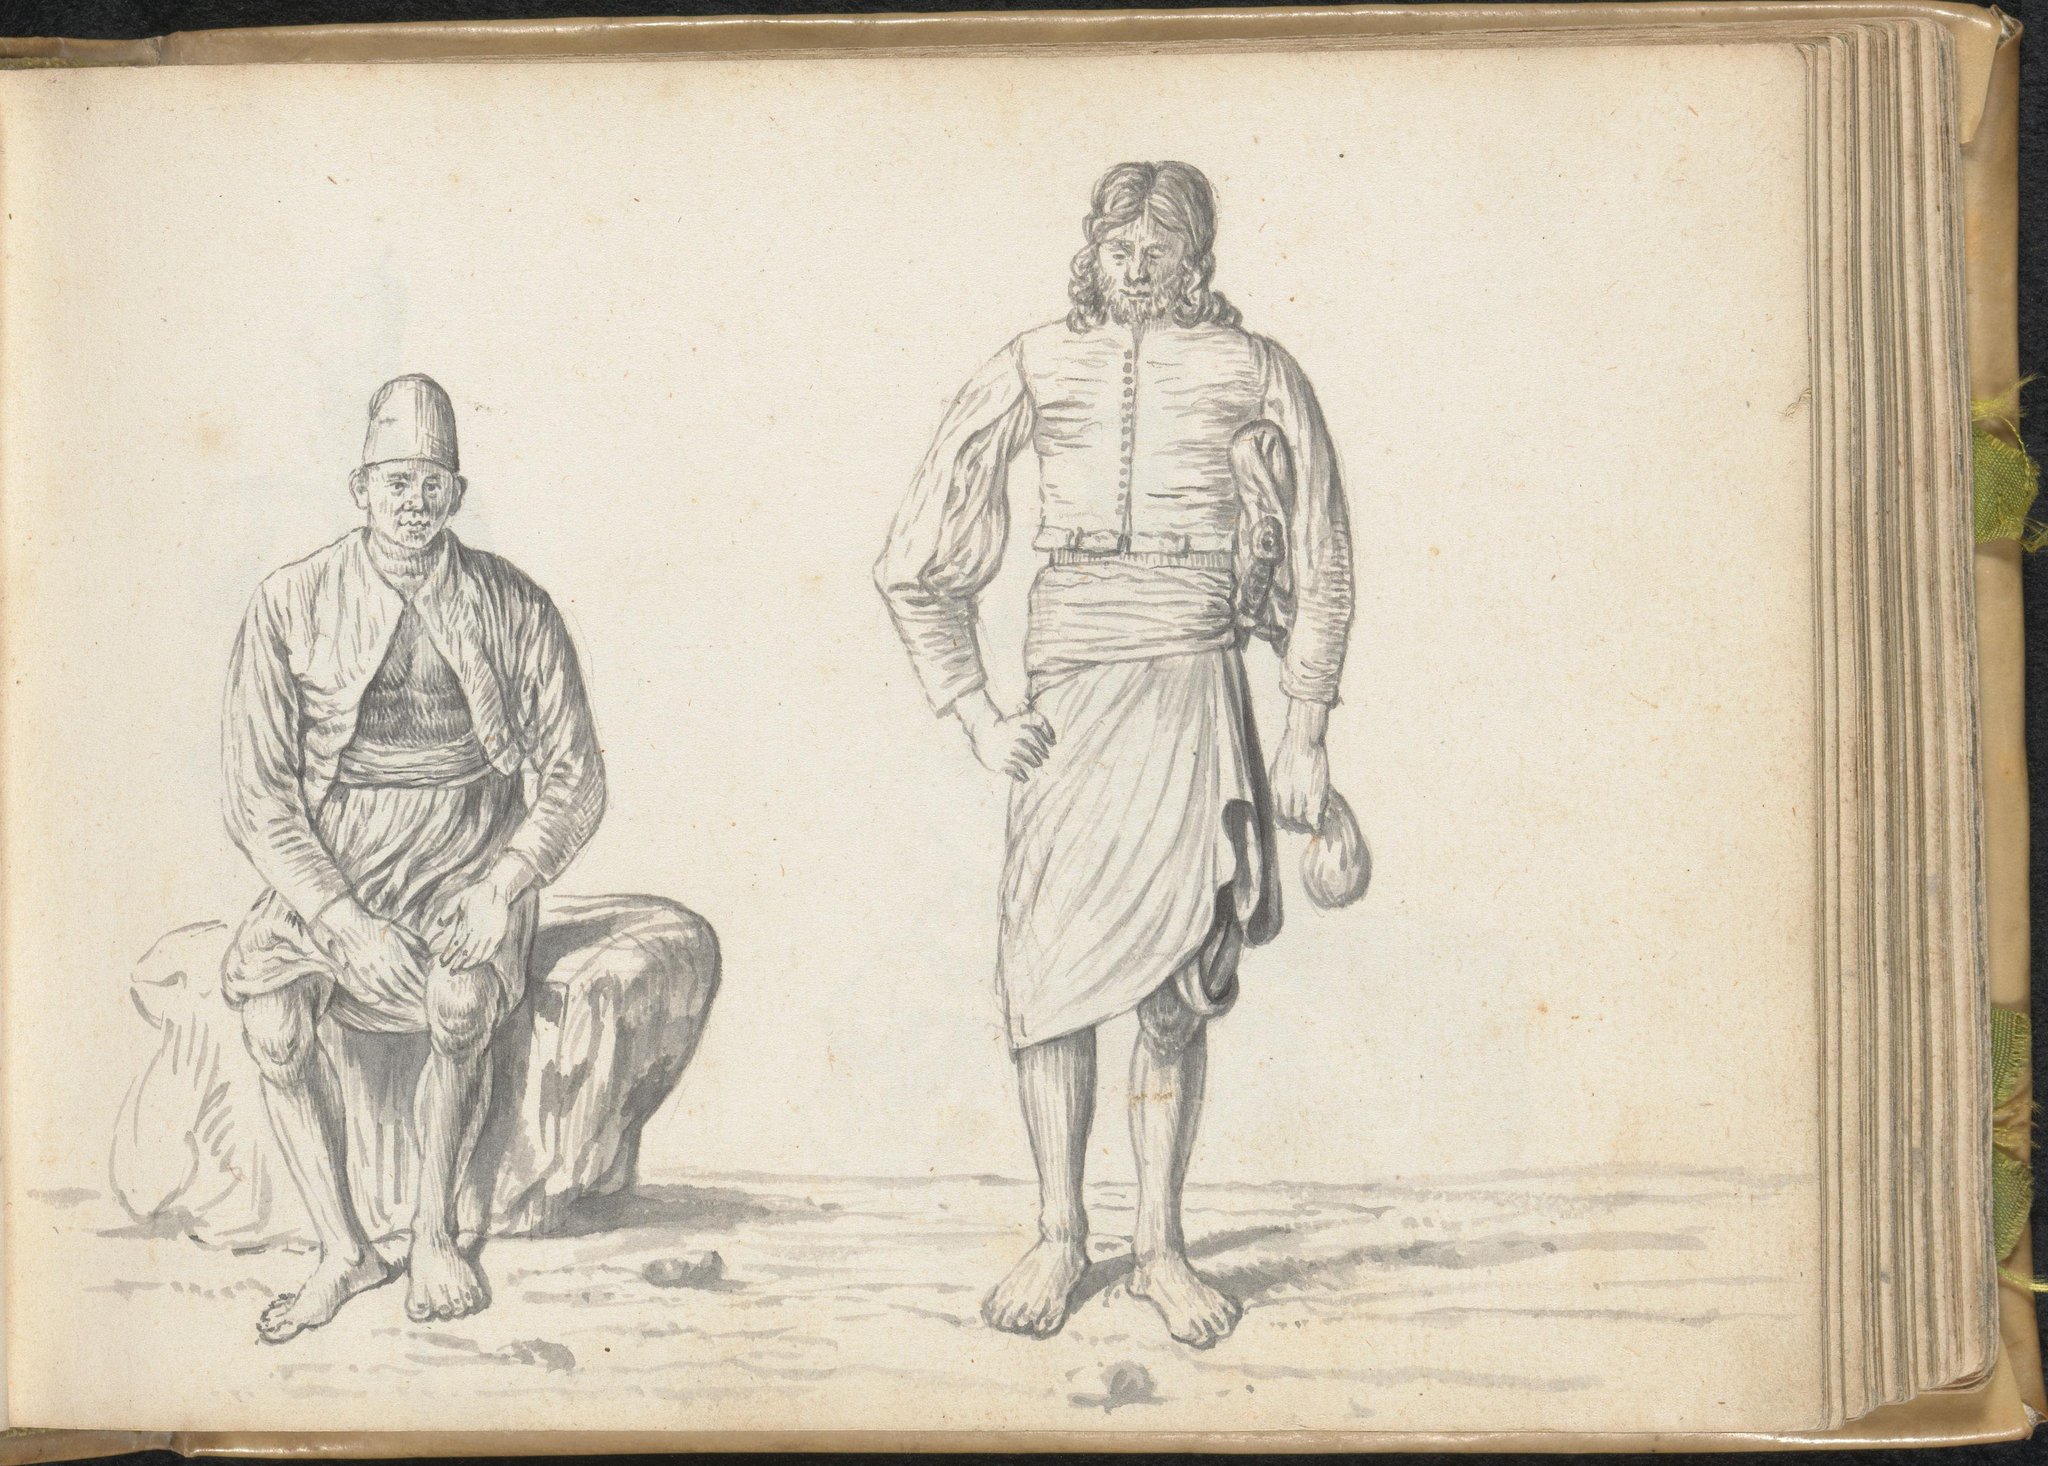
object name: sketchbook leaf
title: Two Sinhalese soldiers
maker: esaias boursse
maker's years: 1631-1672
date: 1662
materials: ink, paper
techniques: brush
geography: sri lanka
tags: asiatic races and peoples (srilankans), asiatic races and peoples (with name), skirt (dhoti), 41d232(...) skirt (lungi), hacing and thrusting weapons (with name), the soldier; the soldier's life, sri lanka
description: In de buitenlucht poseren twee mannen frontaal voor de tekenaar. Hun voeten en onderbenen zijn bloot. De man links zit op een rotsblok. Hij draagt een tot boven de knieën opgeschort heupkleed (veshti, lungi) met een tailleband, een openhangend kort jasje met lange mouwen en geplooide onderrand (hettaya) en een eenvoudige hoge muts op zijn hoofd boven zijn oren. De man rechts heeft lang krullend haar tot op de schouders, in het midden gescheiden, en een korte baard. Ook hij draagt een knielang heupkleed, een brede tailleband en een kort dichtgeknoopt jasje met lange mouwen en geplooide onderrand (hettaya). Op zijn linkerheup is het versierde gevest van een kort zwaard (kastane) te zien. Onder de linkeroksel is een opgerolde doek geklemd. Het voorwerp in zijn linkerhand is waarschijnlijk een muts. Beide mannen zijn Singalese huursoldaten (lascorijnen), nu in dienst van de Nederlanders. Ze horen tot de kaste der Goviiya. Blad 3 uit een schetsboek met 117 bladen.